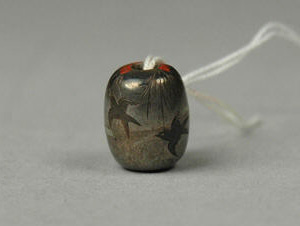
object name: ojime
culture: japanese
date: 1801-1900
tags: birds